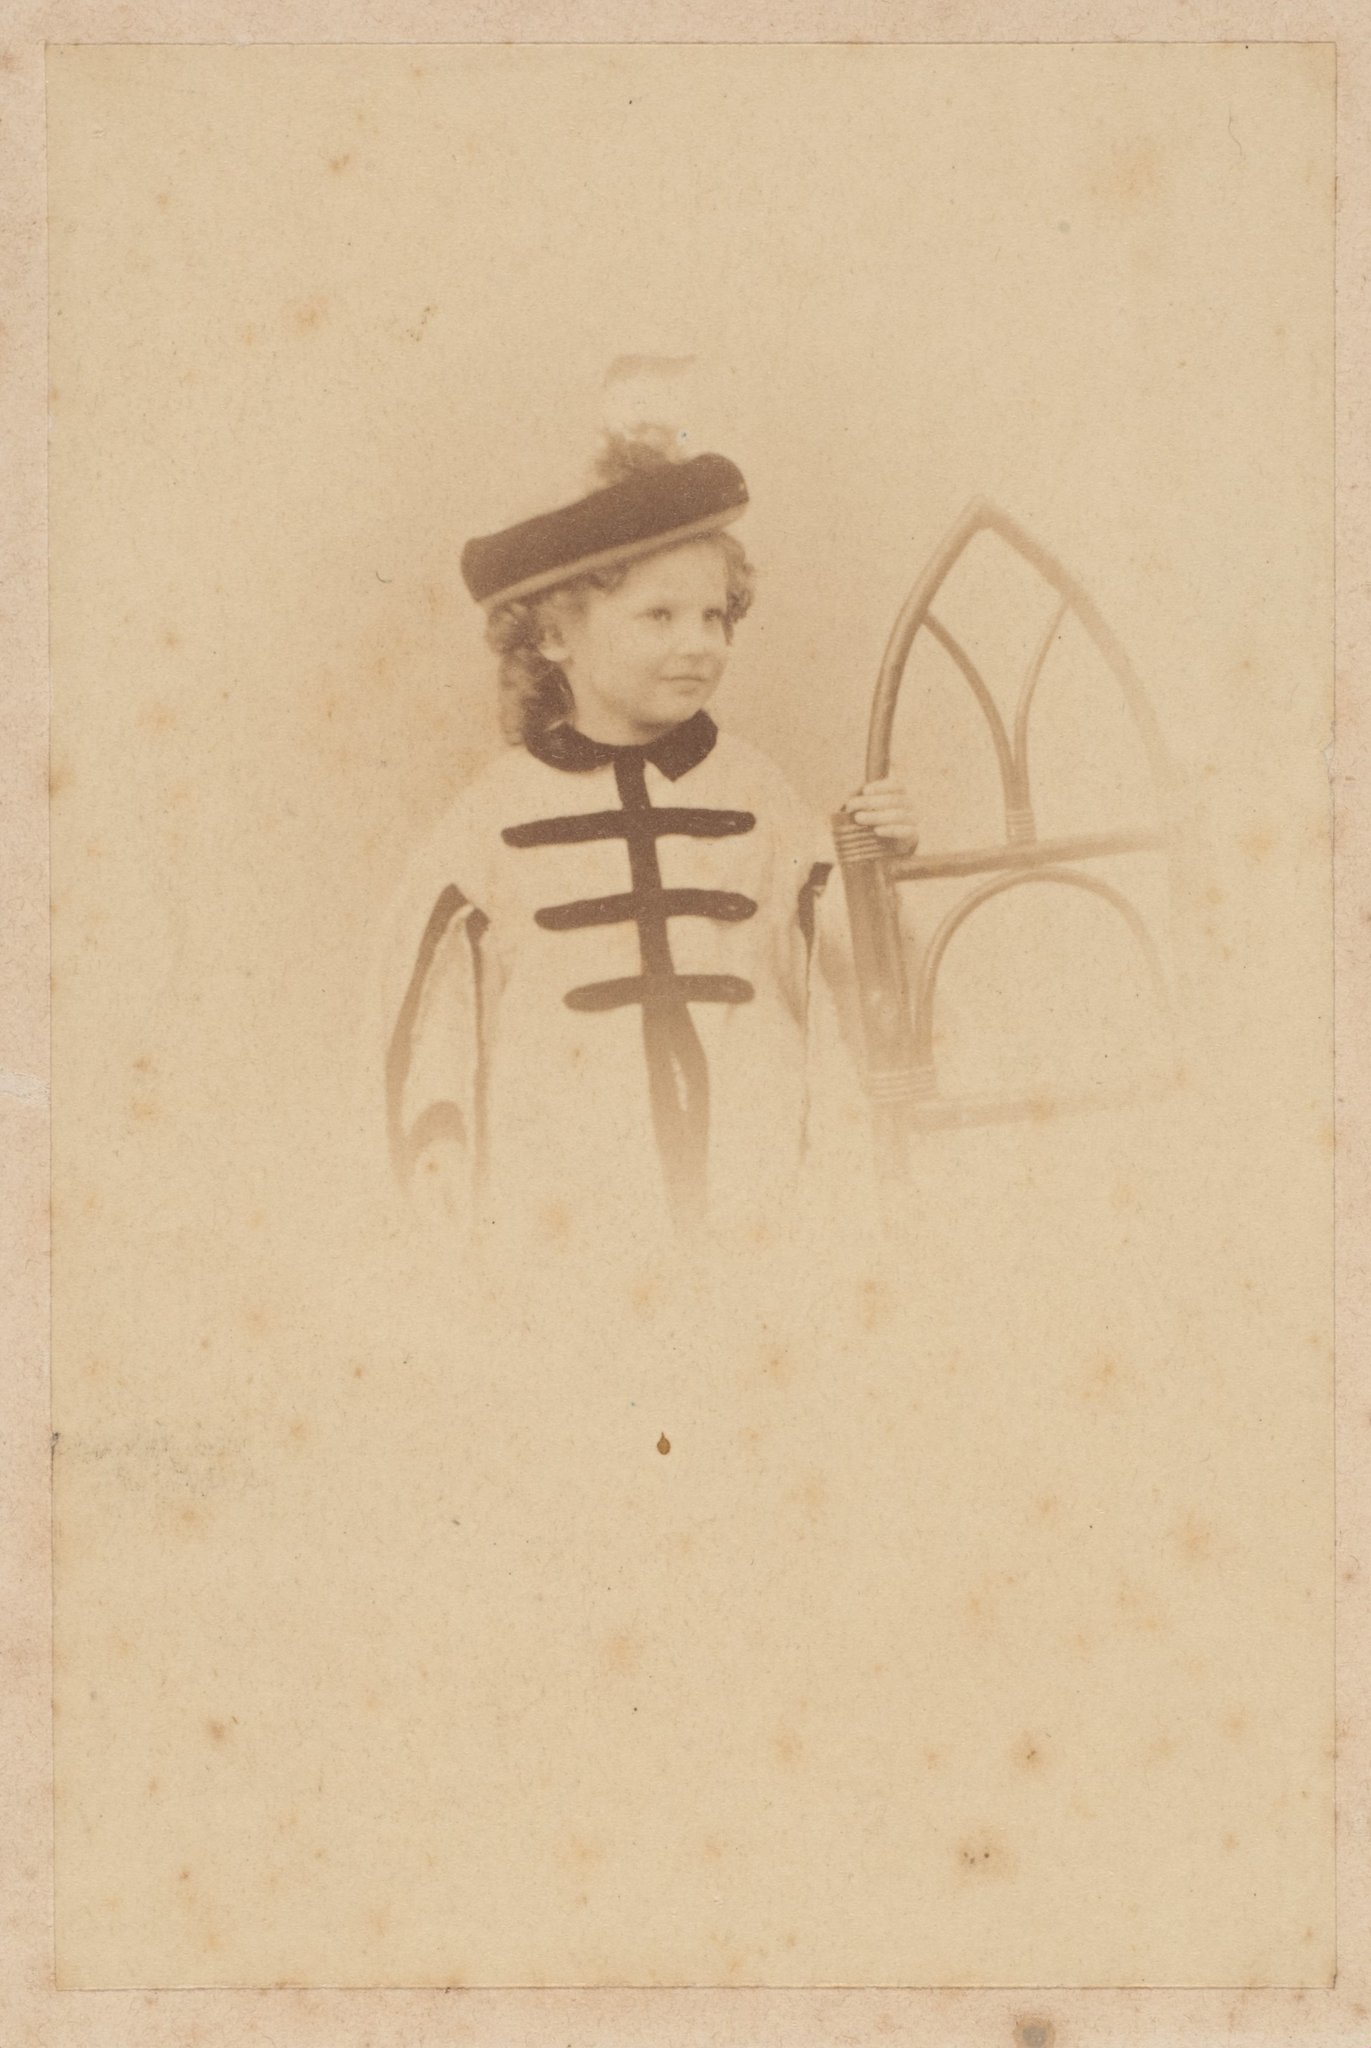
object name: photograph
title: La chaise rustique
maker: pierre-louis pierson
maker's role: artist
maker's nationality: french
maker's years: 1822-1913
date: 1860-1869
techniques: albumen silver print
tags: children,portraits